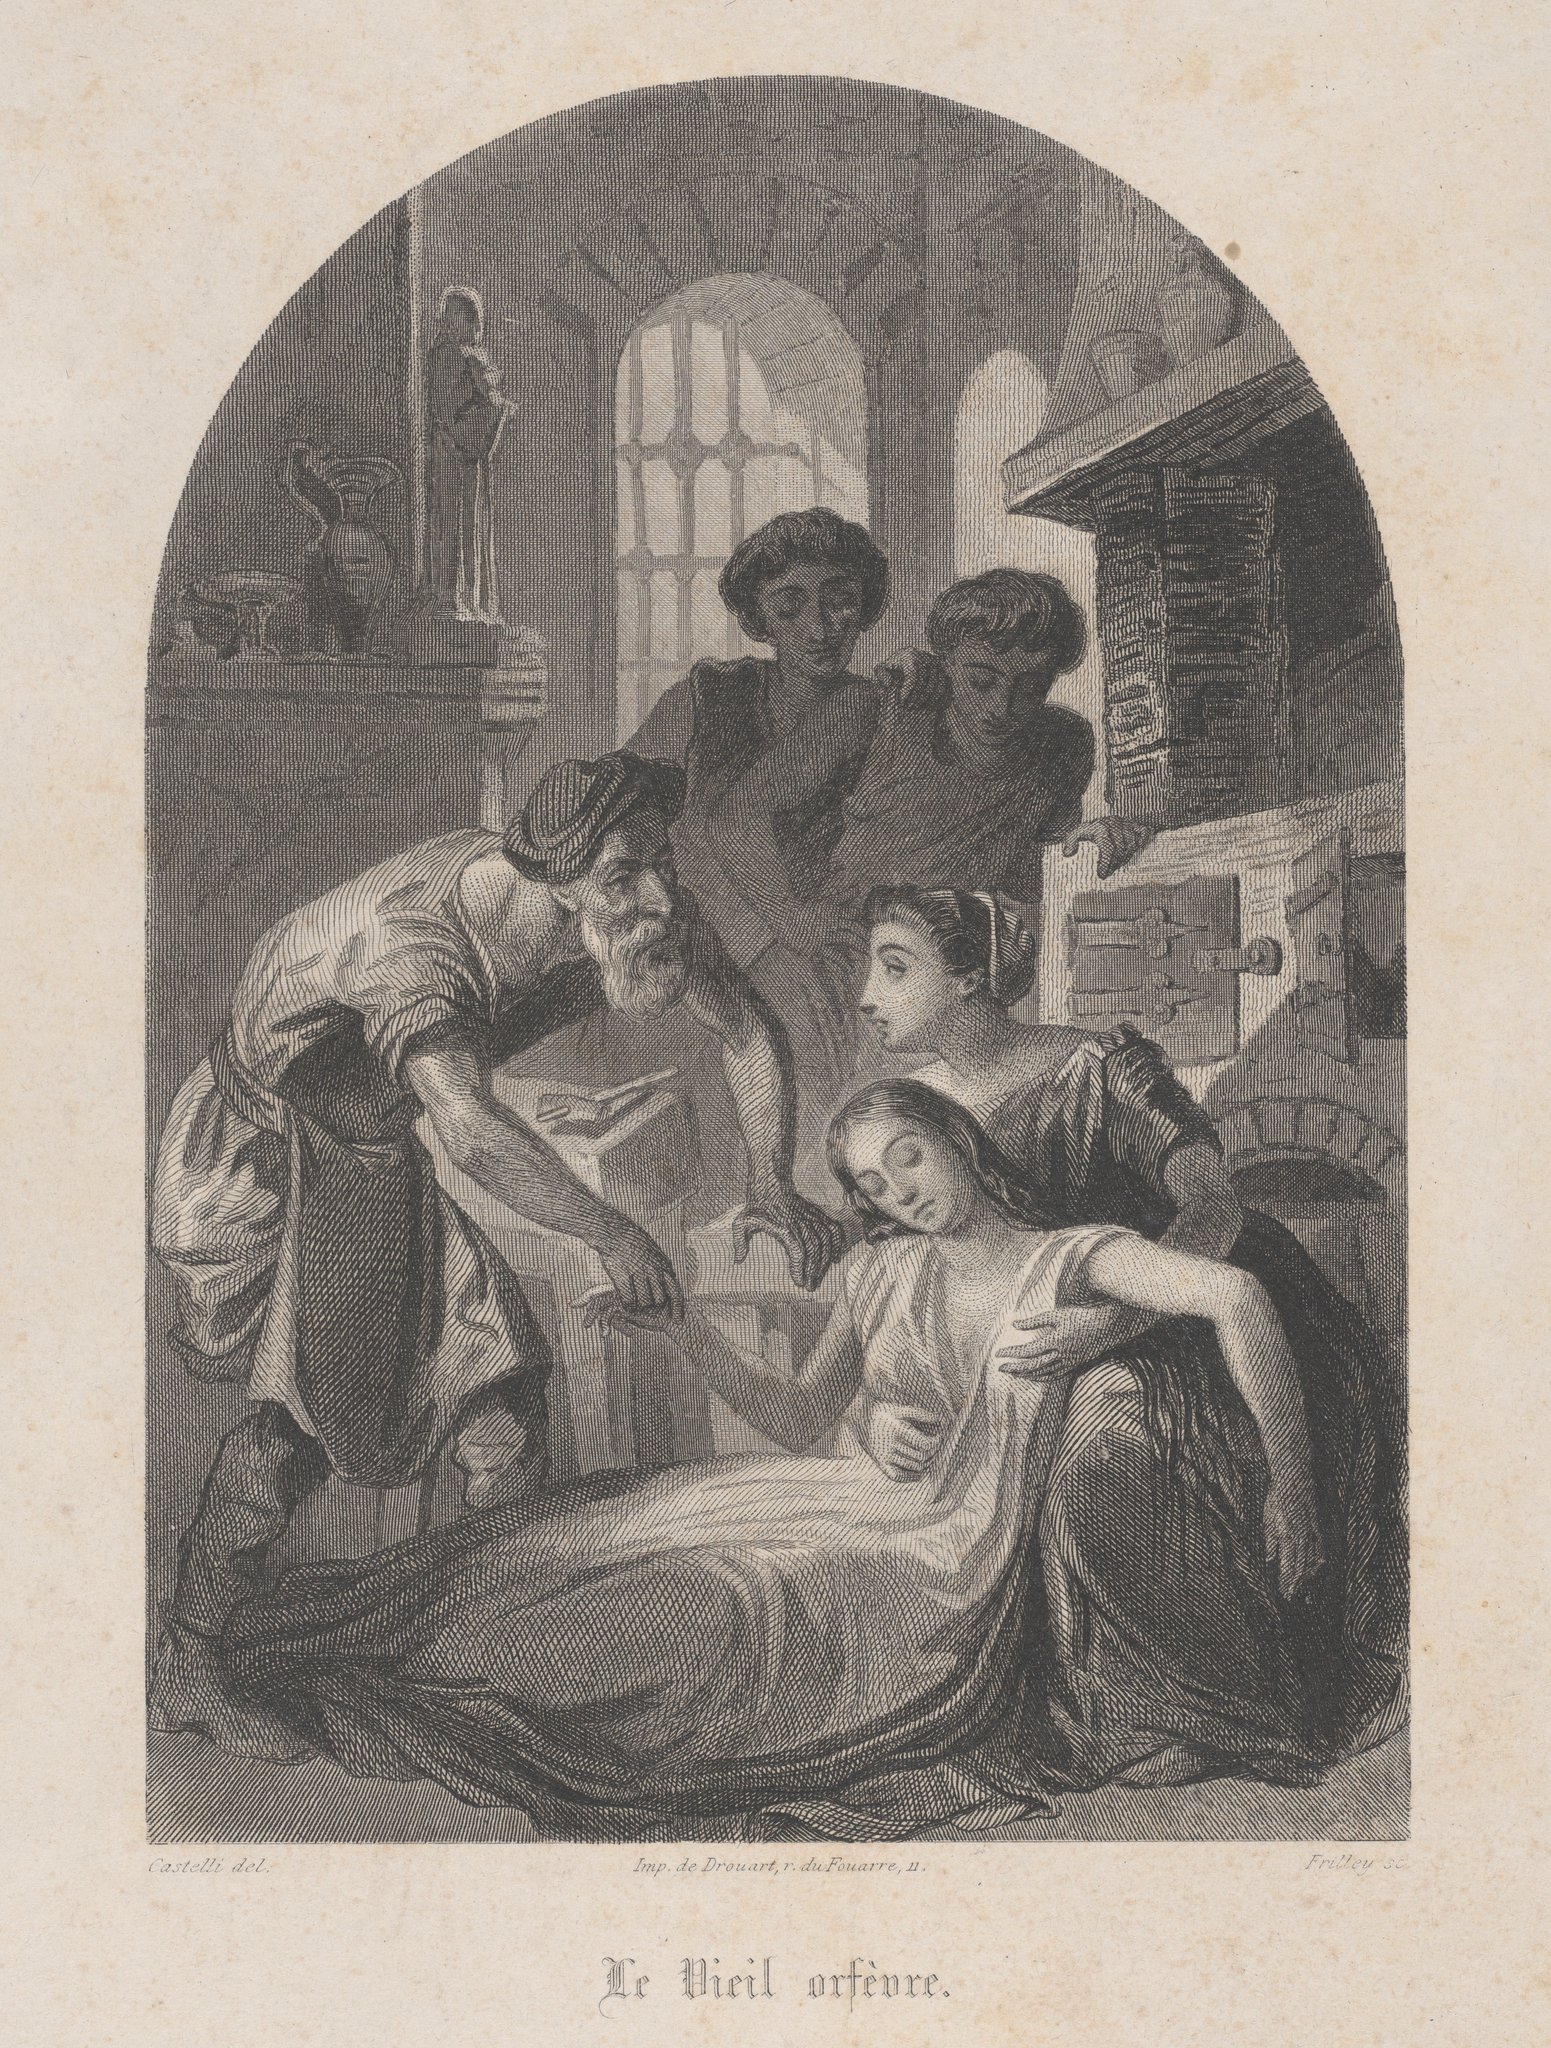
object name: print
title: The elderly goldsmith (Le vieil orfèvre)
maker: jean jacques frilley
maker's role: artist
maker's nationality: french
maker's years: 1797-1850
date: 1824-1861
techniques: etching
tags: men,women